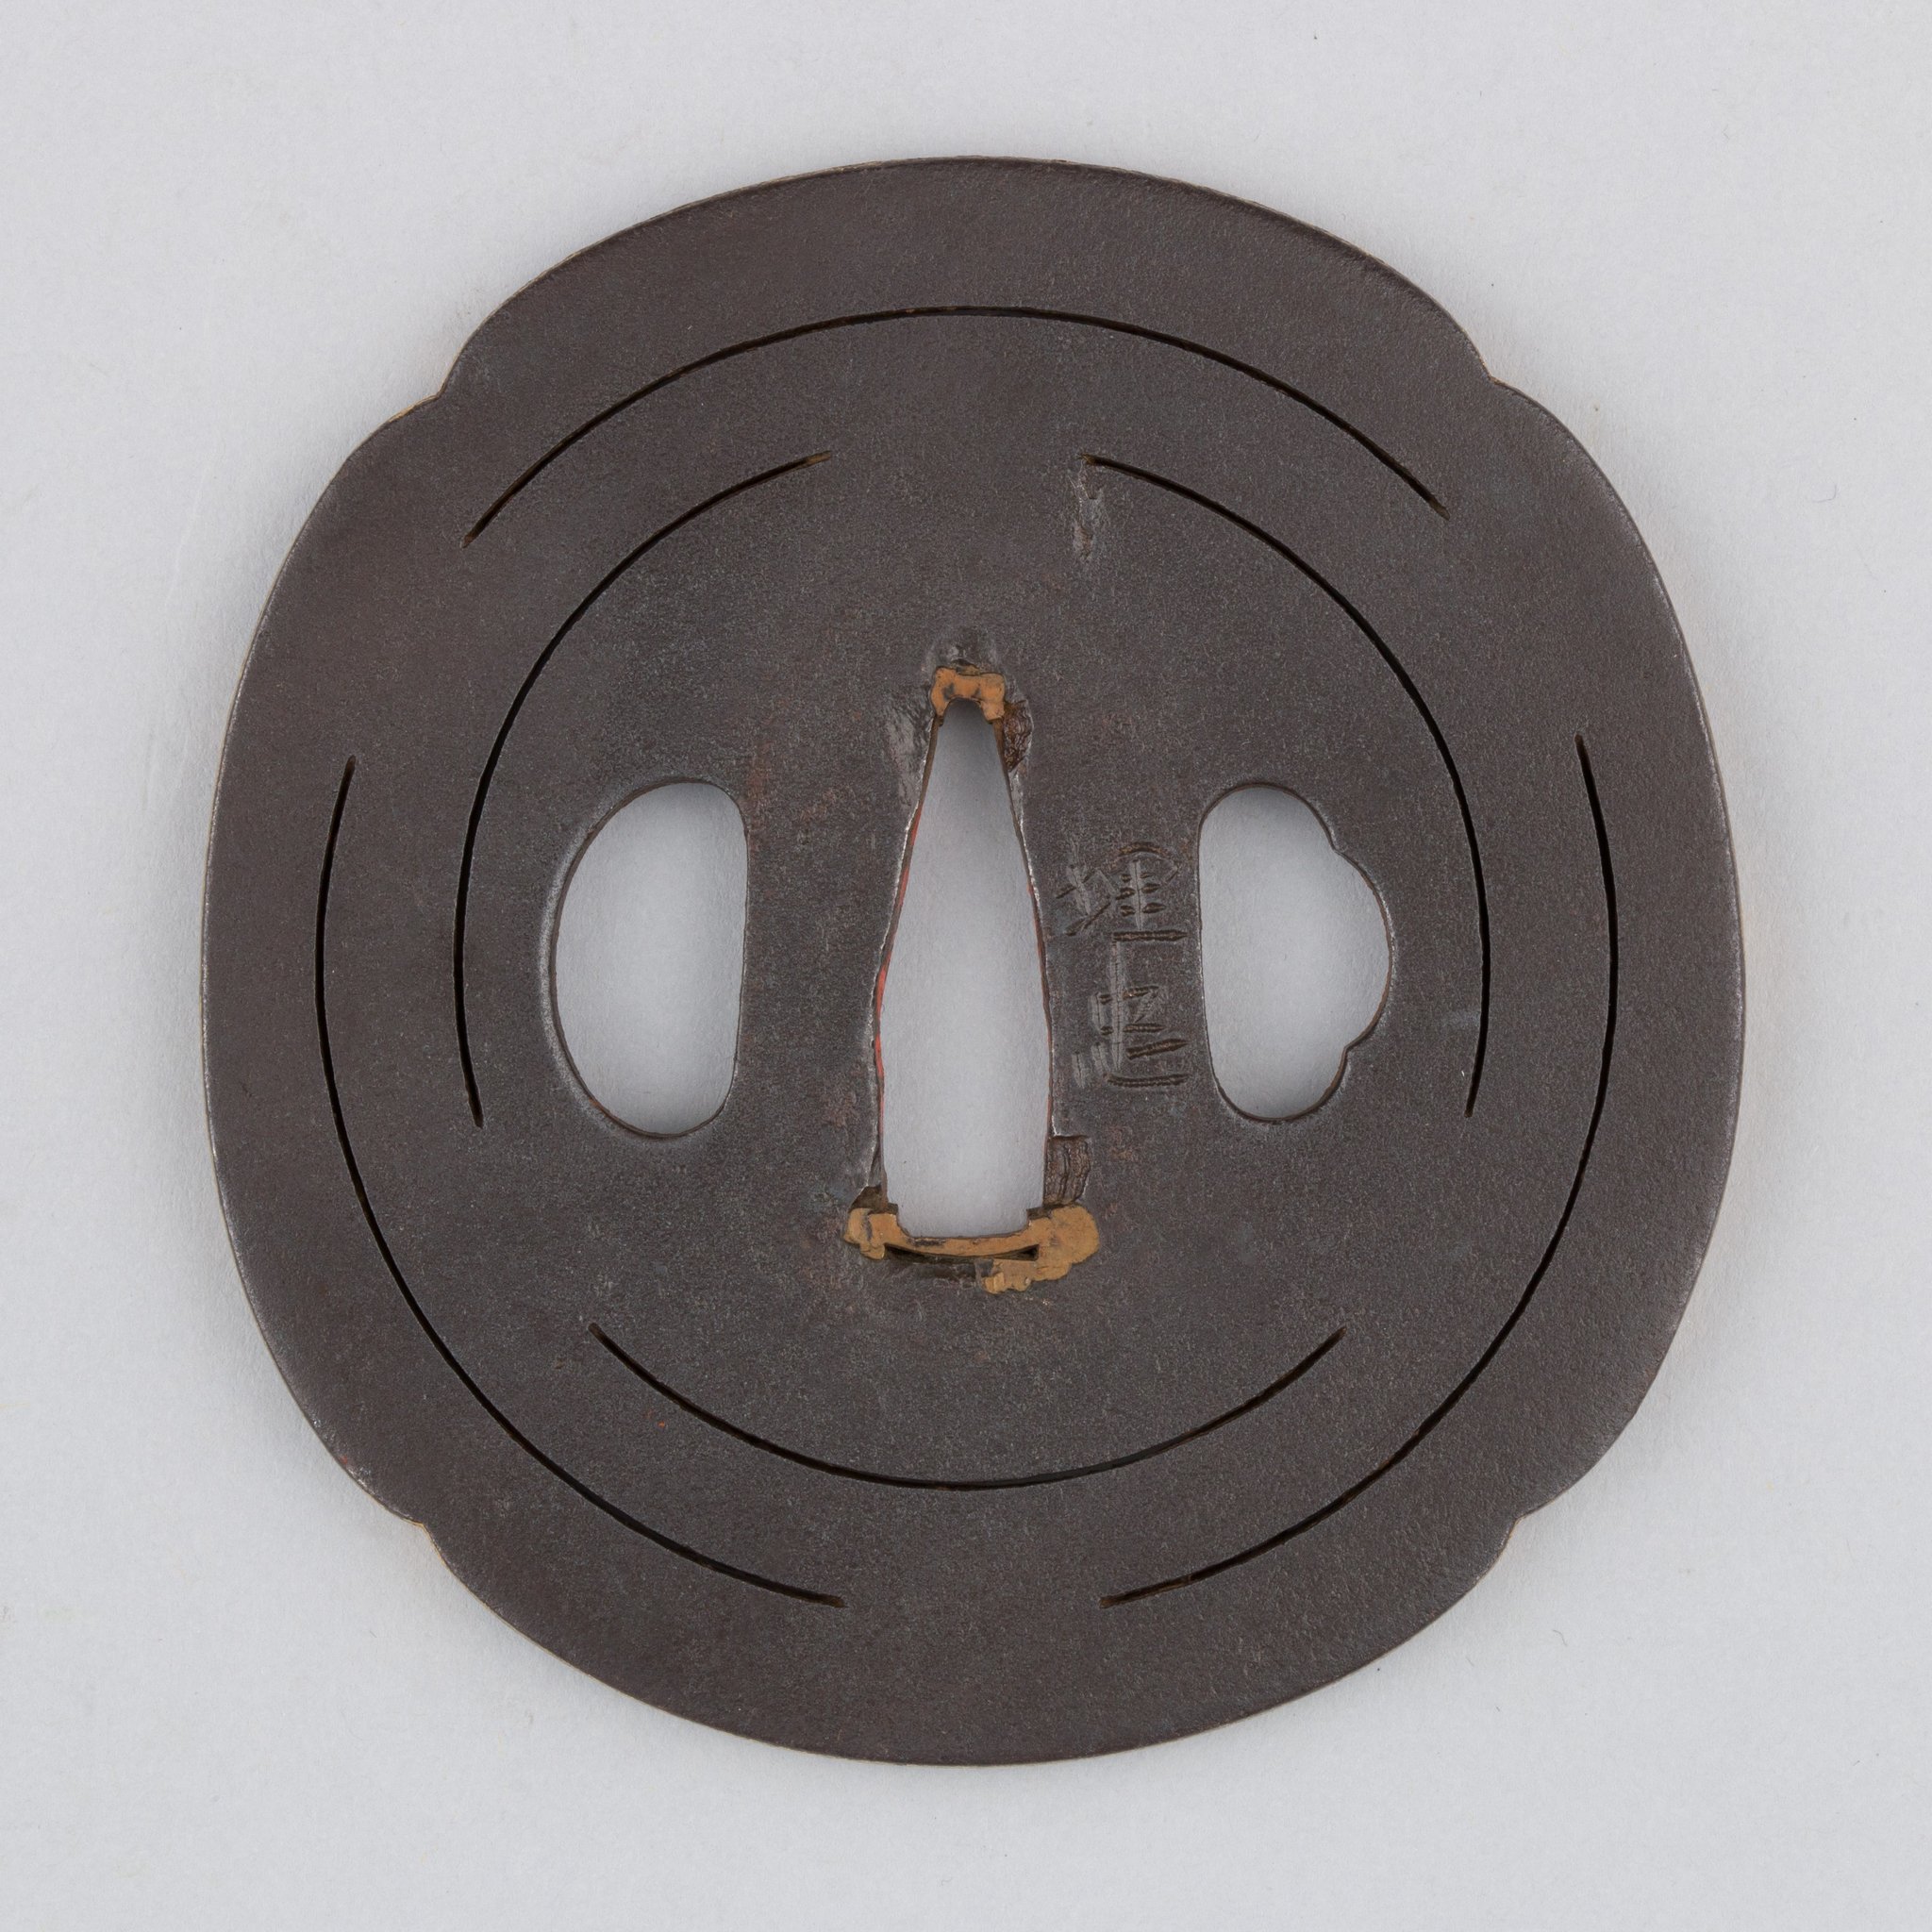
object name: sword guard tsuba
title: Sword Guard (Tsuba)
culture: japanese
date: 1601-1700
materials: copper, gold, iron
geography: japan